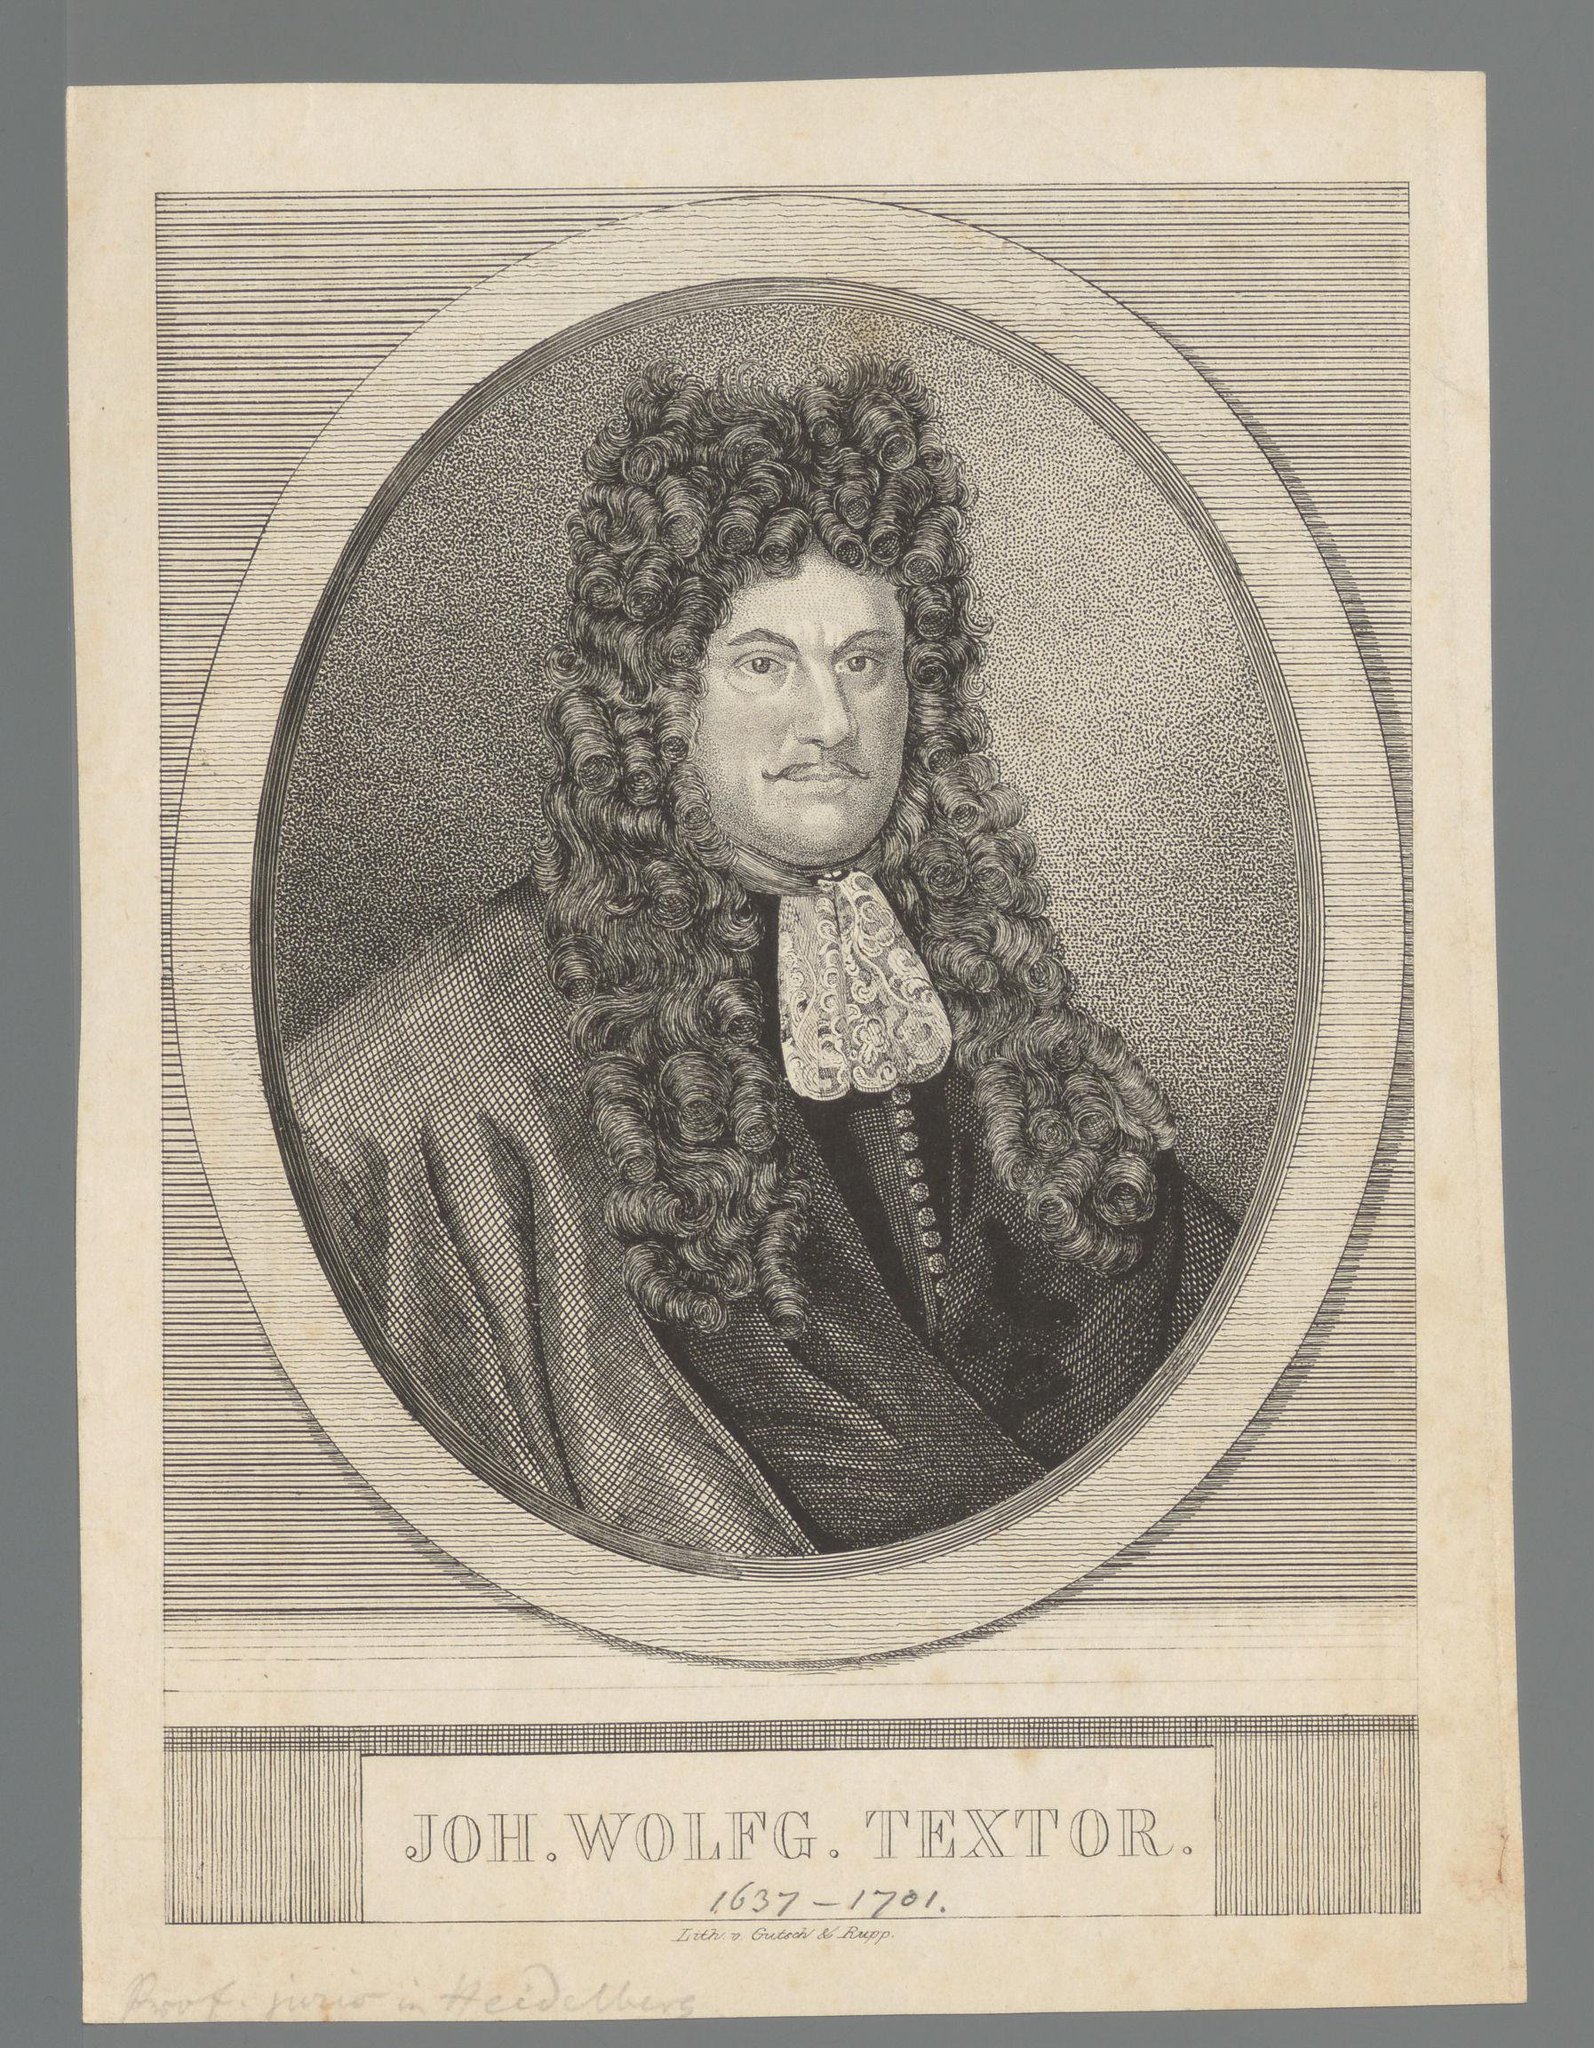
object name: print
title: Joh. Wolfg. Textor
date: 1820-1860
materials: paper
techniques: lithograph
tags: adult man, historical persons, wig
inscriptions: collector's mark: Lugt 2228